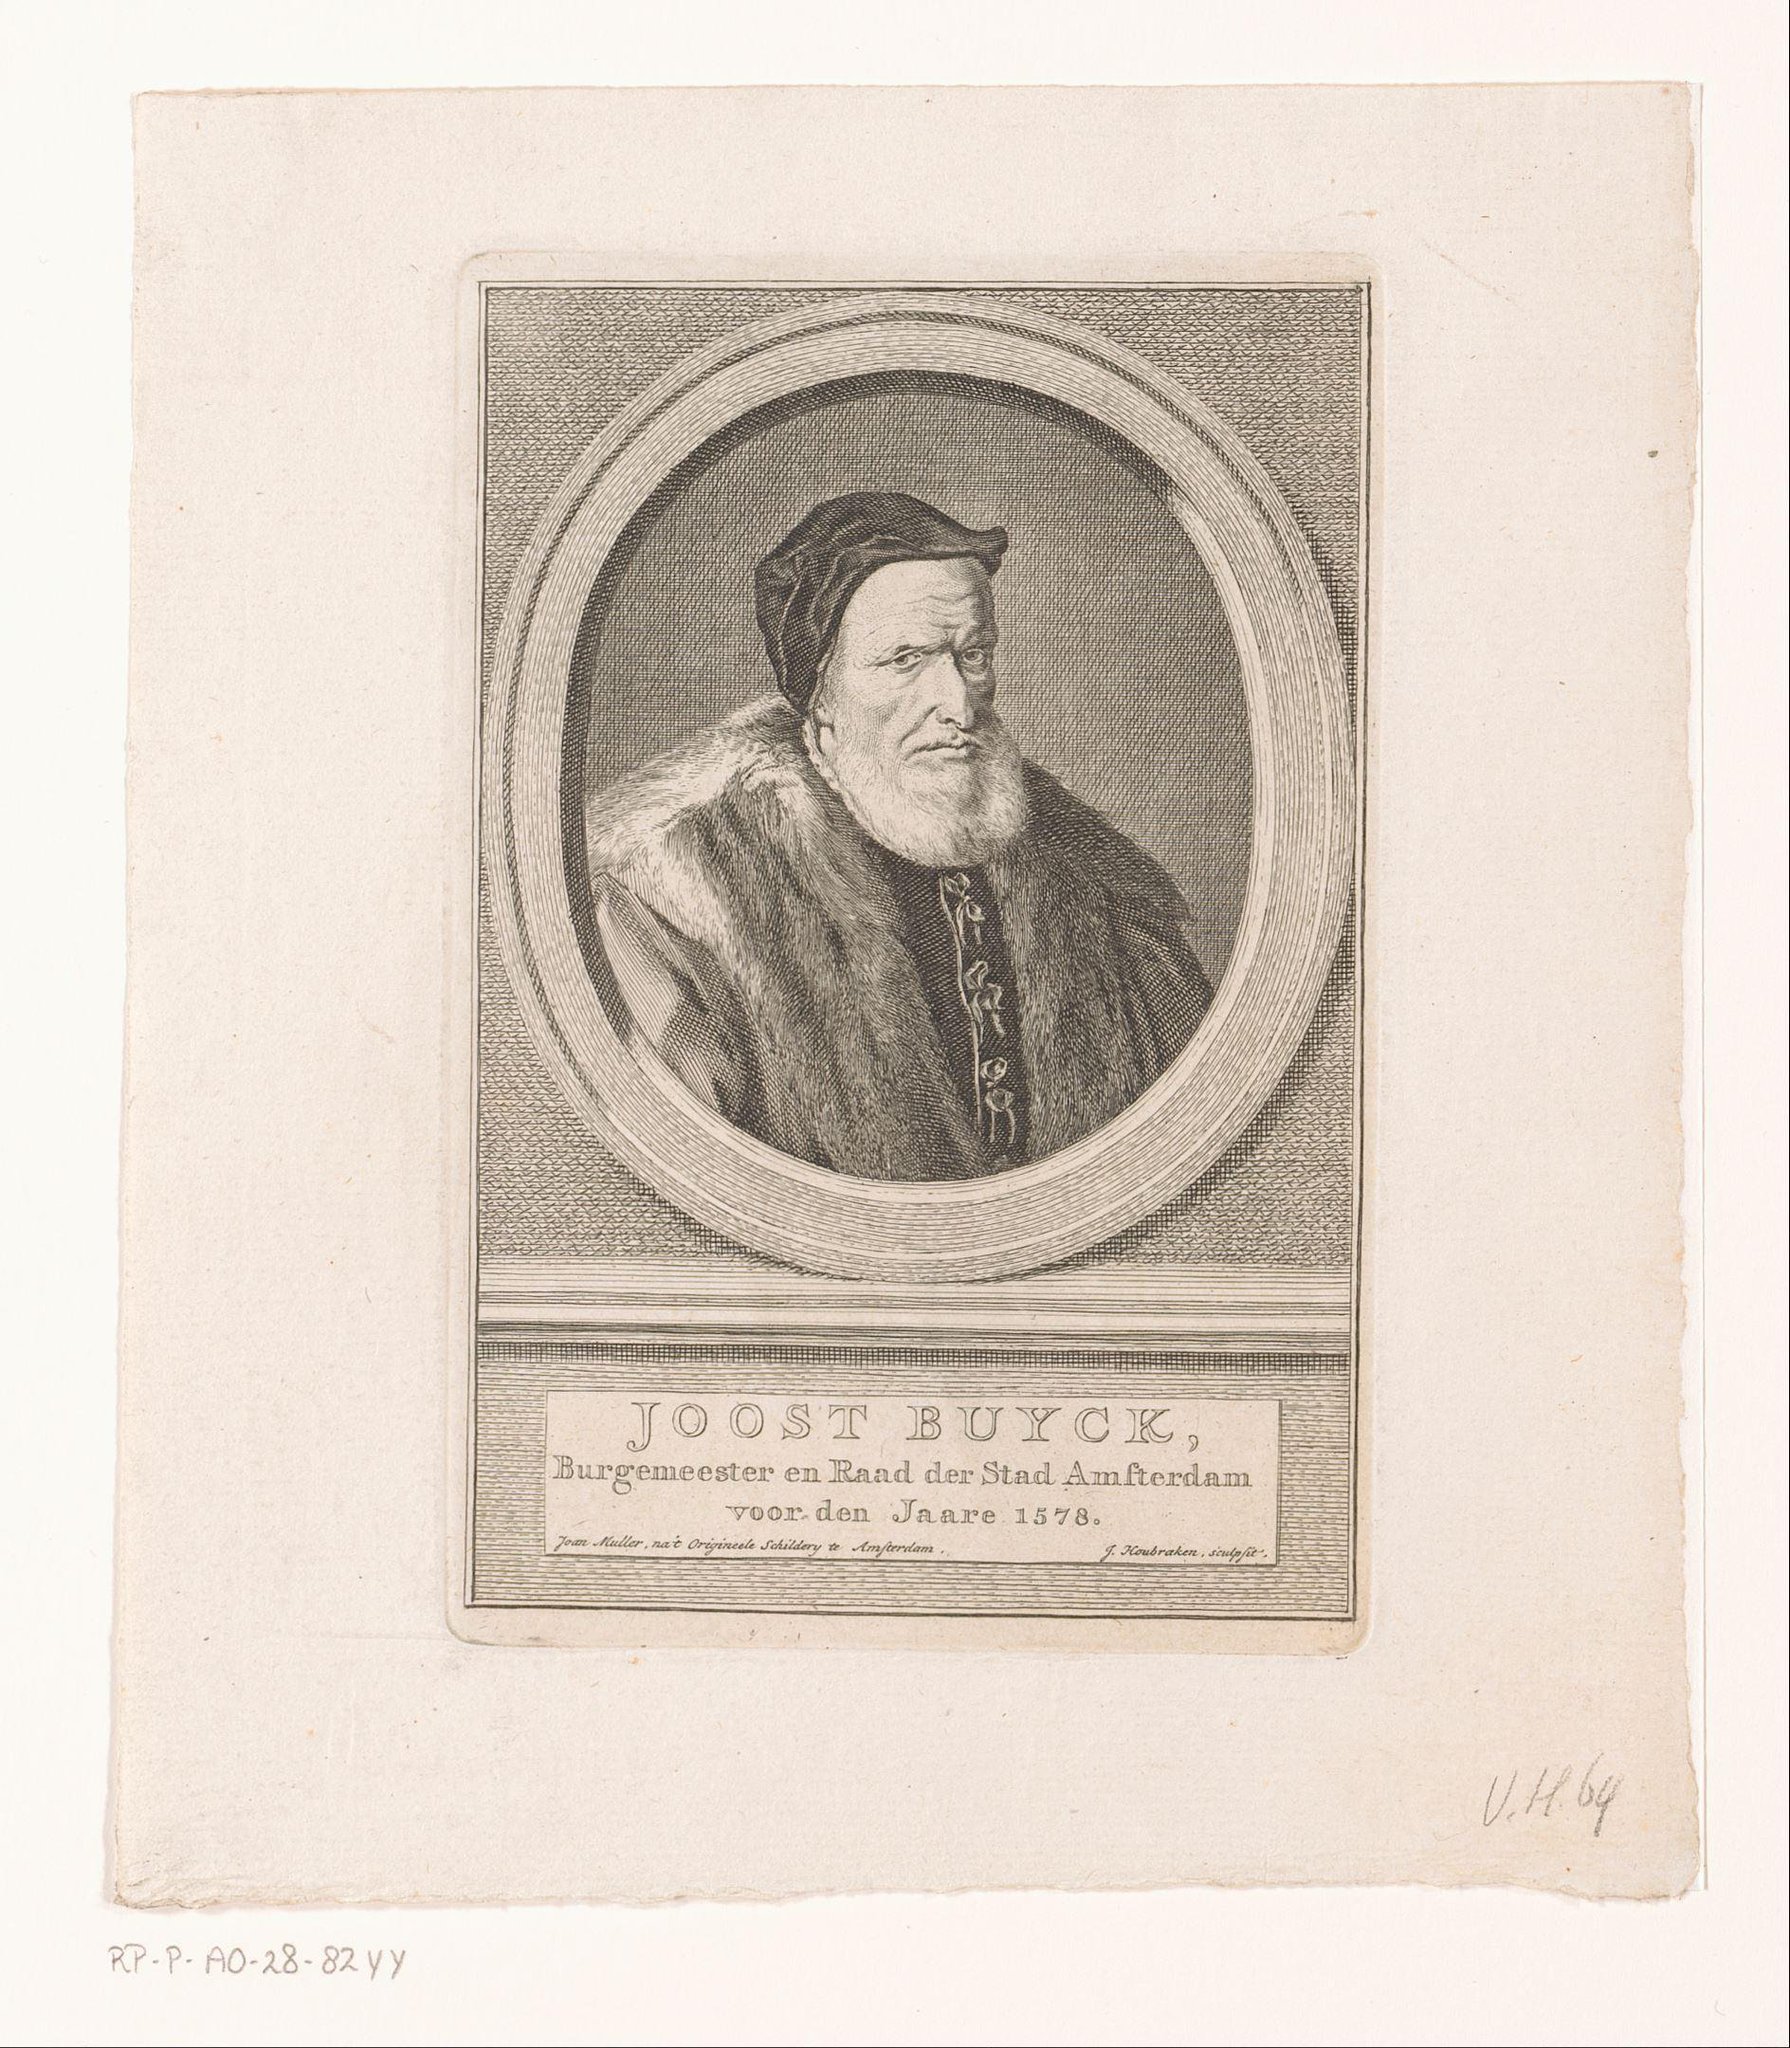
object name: print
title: Portret van Joost Sijbrandtsz. Buyck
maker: jan harmensz. muller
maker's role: draughtsman, print maker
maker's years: 1571-1628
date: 1588-1628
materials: paper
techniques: engraving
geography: amsterdam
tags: amsterdam, leiden, mayor, historical persons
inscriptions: collector's mark: Lugt 2228, collector's mark: Lugt 195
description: Portret van Joost Sijbrandtsz. Buyck op 82-jarige leeftijd, gezeten in een stoel aan tafel, met een bontmantel om zijn schouders. Joost Buyck was meerdere malen burgemeester van Amsterdam.